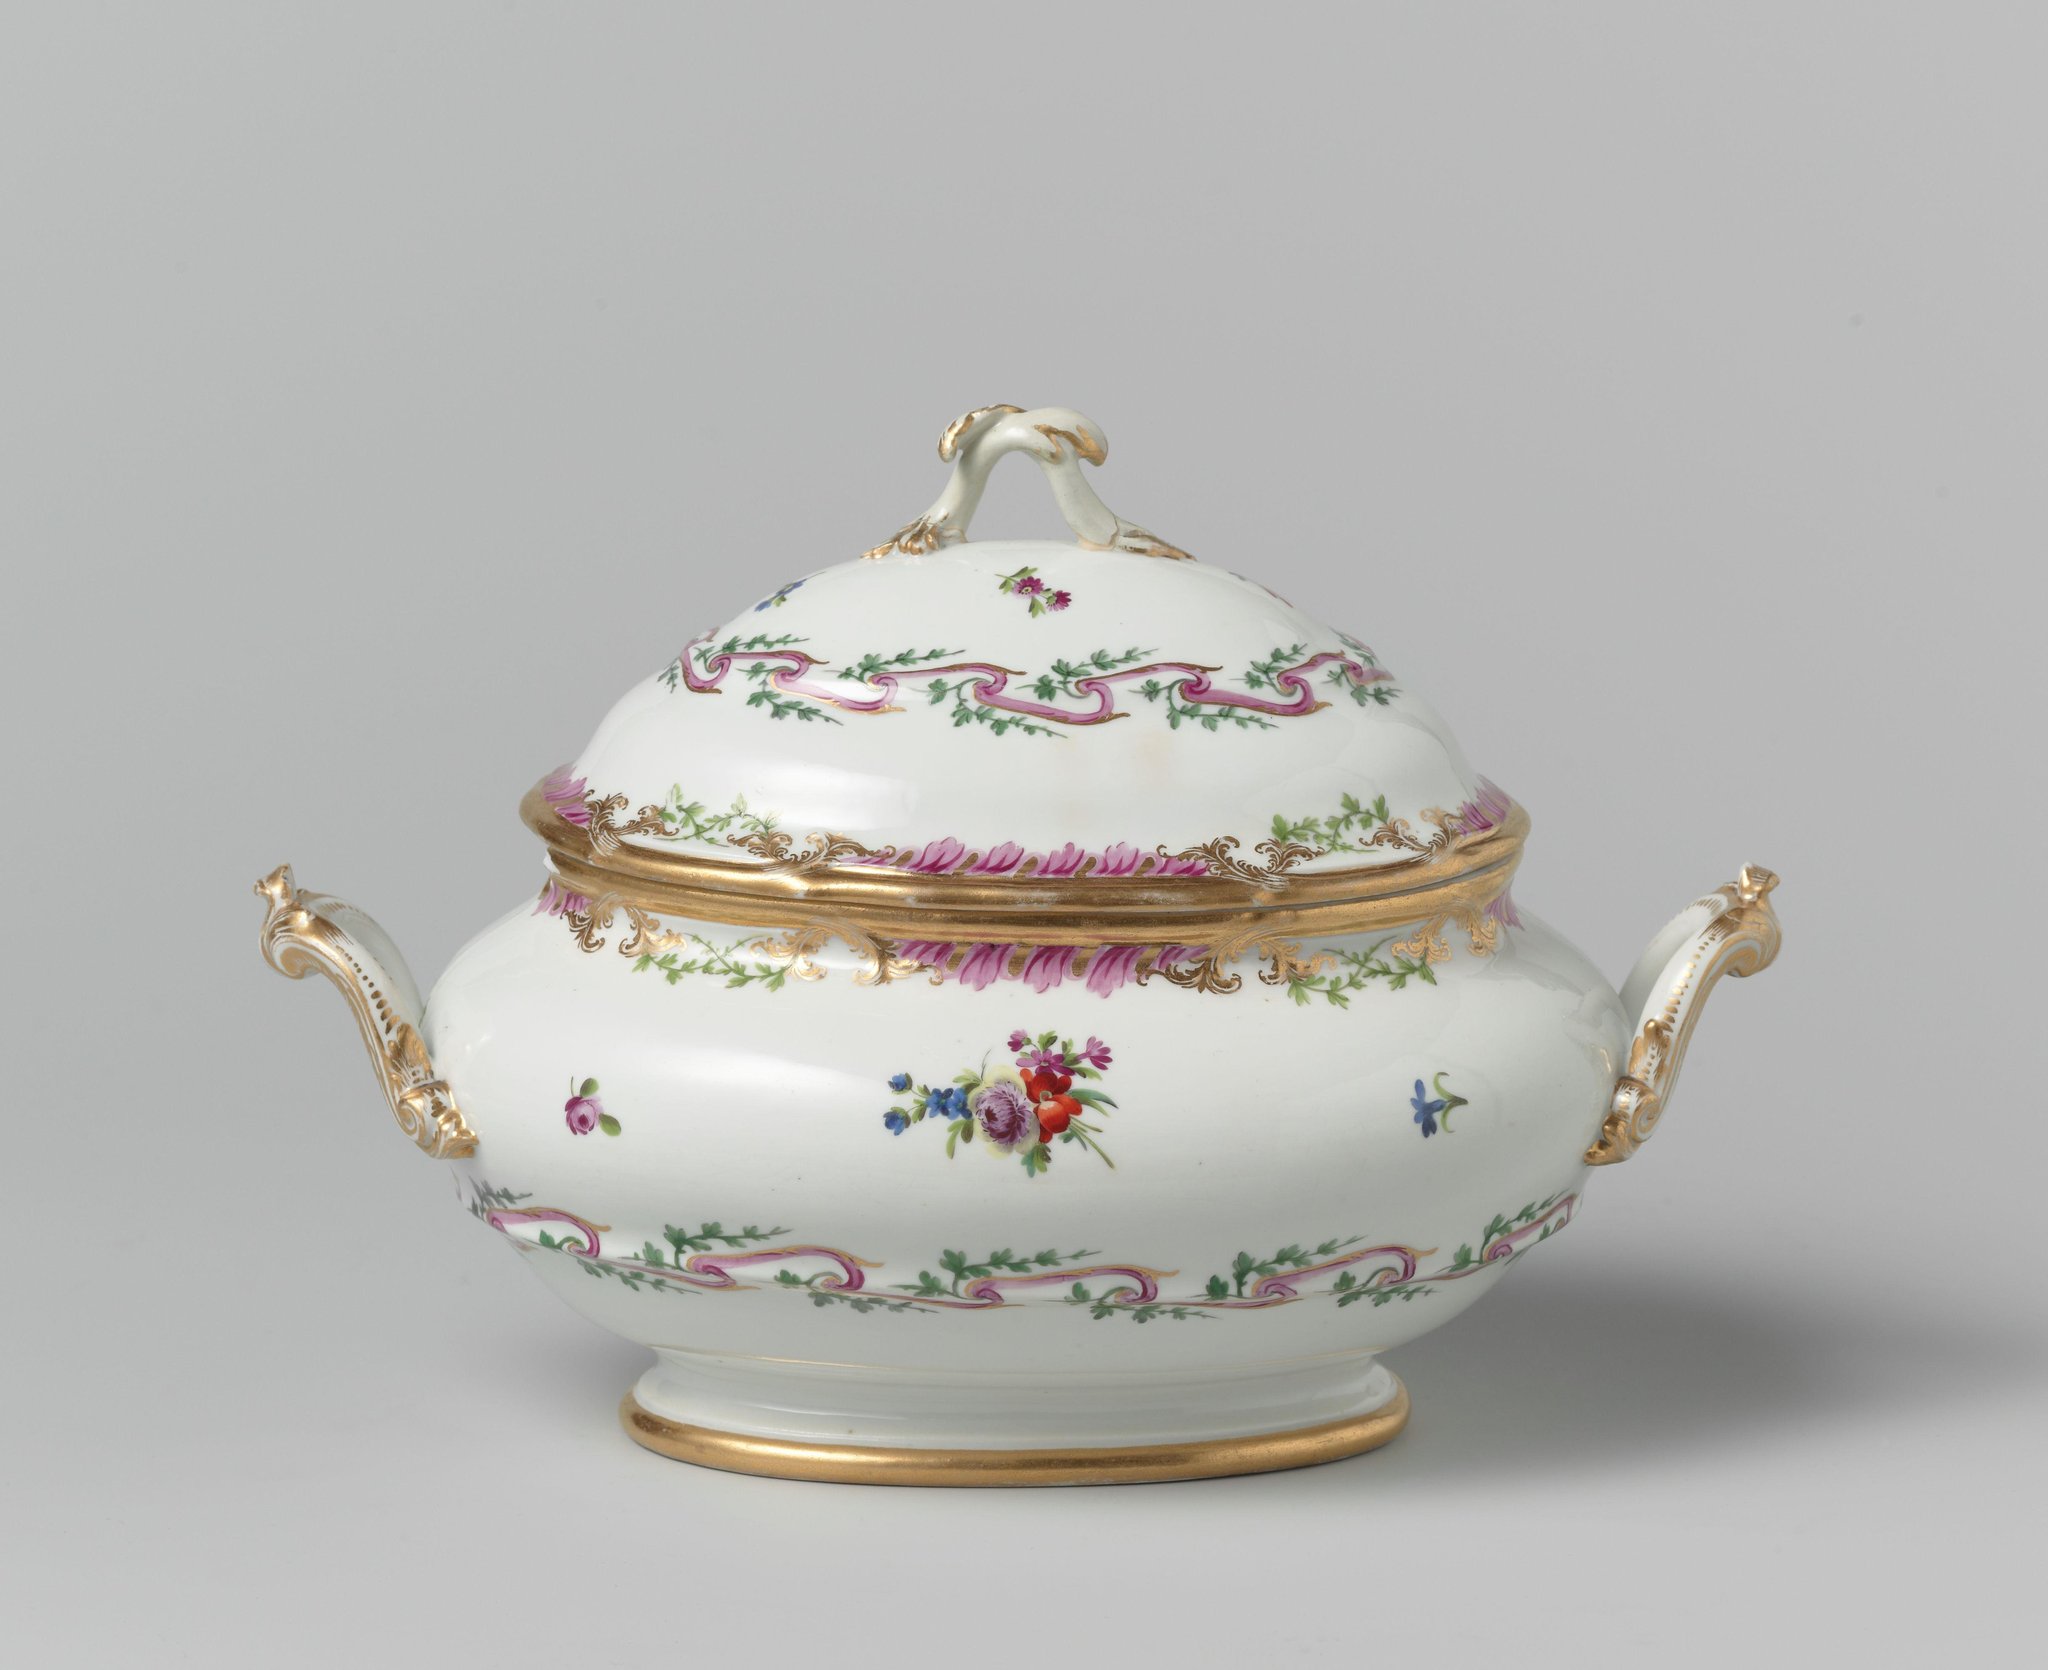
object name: lid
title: Sauceboat, cream pots and plate, part of a service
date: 1784-1809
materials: porcelain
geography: ouder-amstel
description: Onderschotel, behorend bij servies van porselein, versierd met een geslingerd lintmotief in paars en goud met groene bladertakken, bloemboeketten en gestrooide bloemtakken. Randen lichtgegolfd met decoratie in goud met paars bladmotief waartussen groen gekruist bladmotief. Gemerkt: M.O.L. en Amstel.